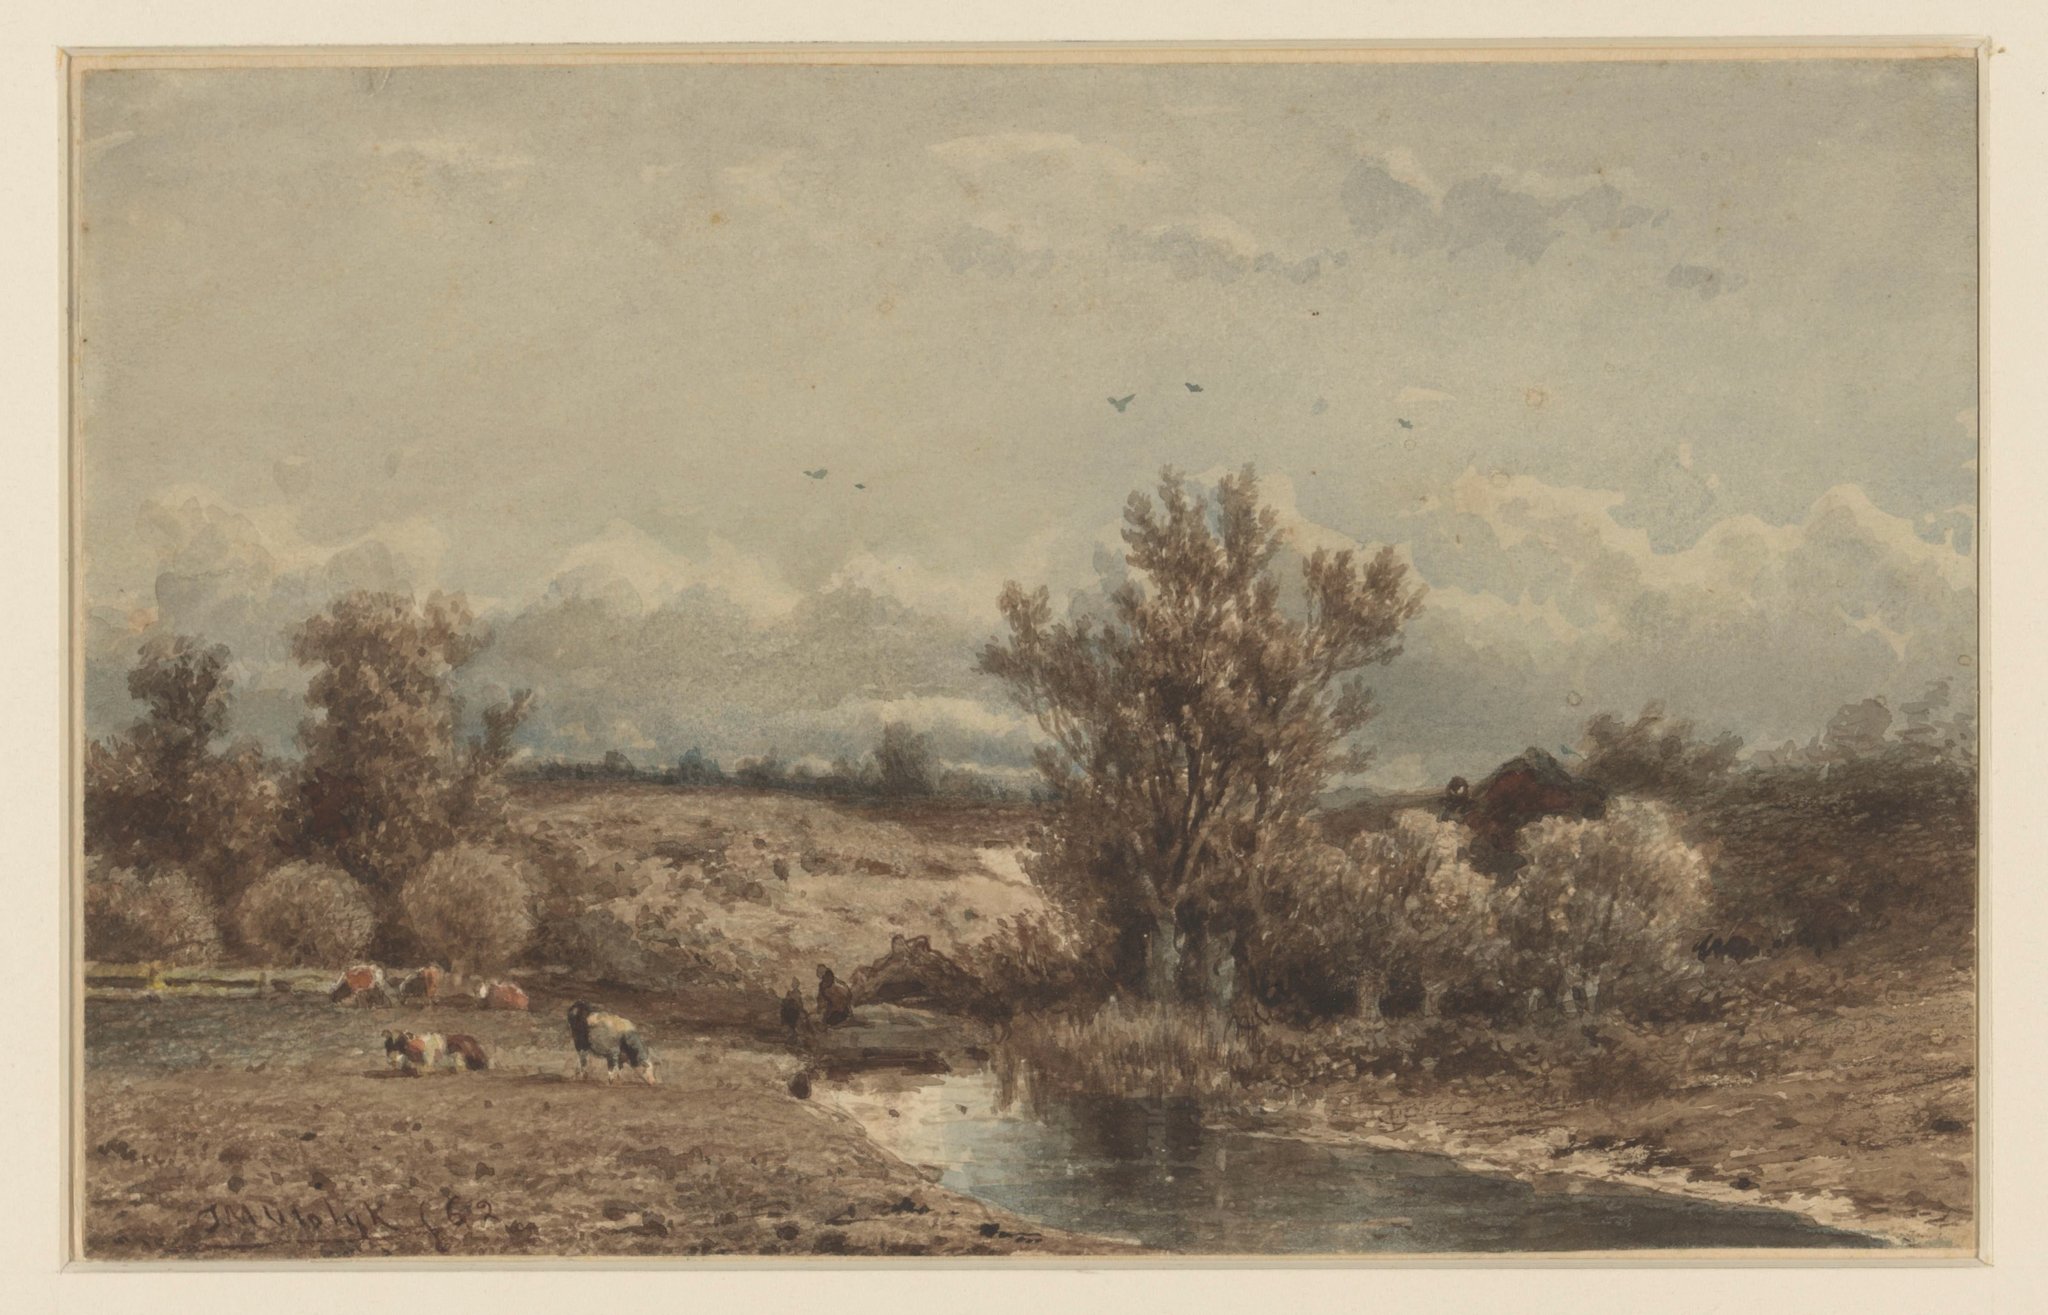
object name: watercolor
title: Landschap met rivier en koeien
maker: jan vrolijk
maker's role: draughtsman, painter, print maker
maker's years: 1846-1894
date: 1862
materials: chalk, paper, watercolor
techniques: brush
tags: low hill country, river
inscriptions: date: ‘62’